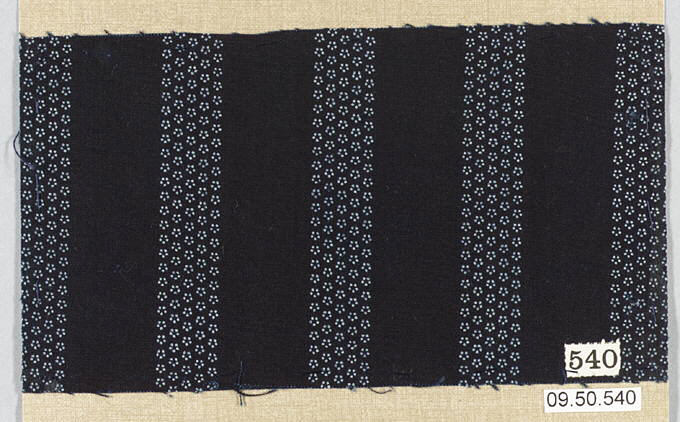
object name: piece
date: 1801-1900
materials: cotton